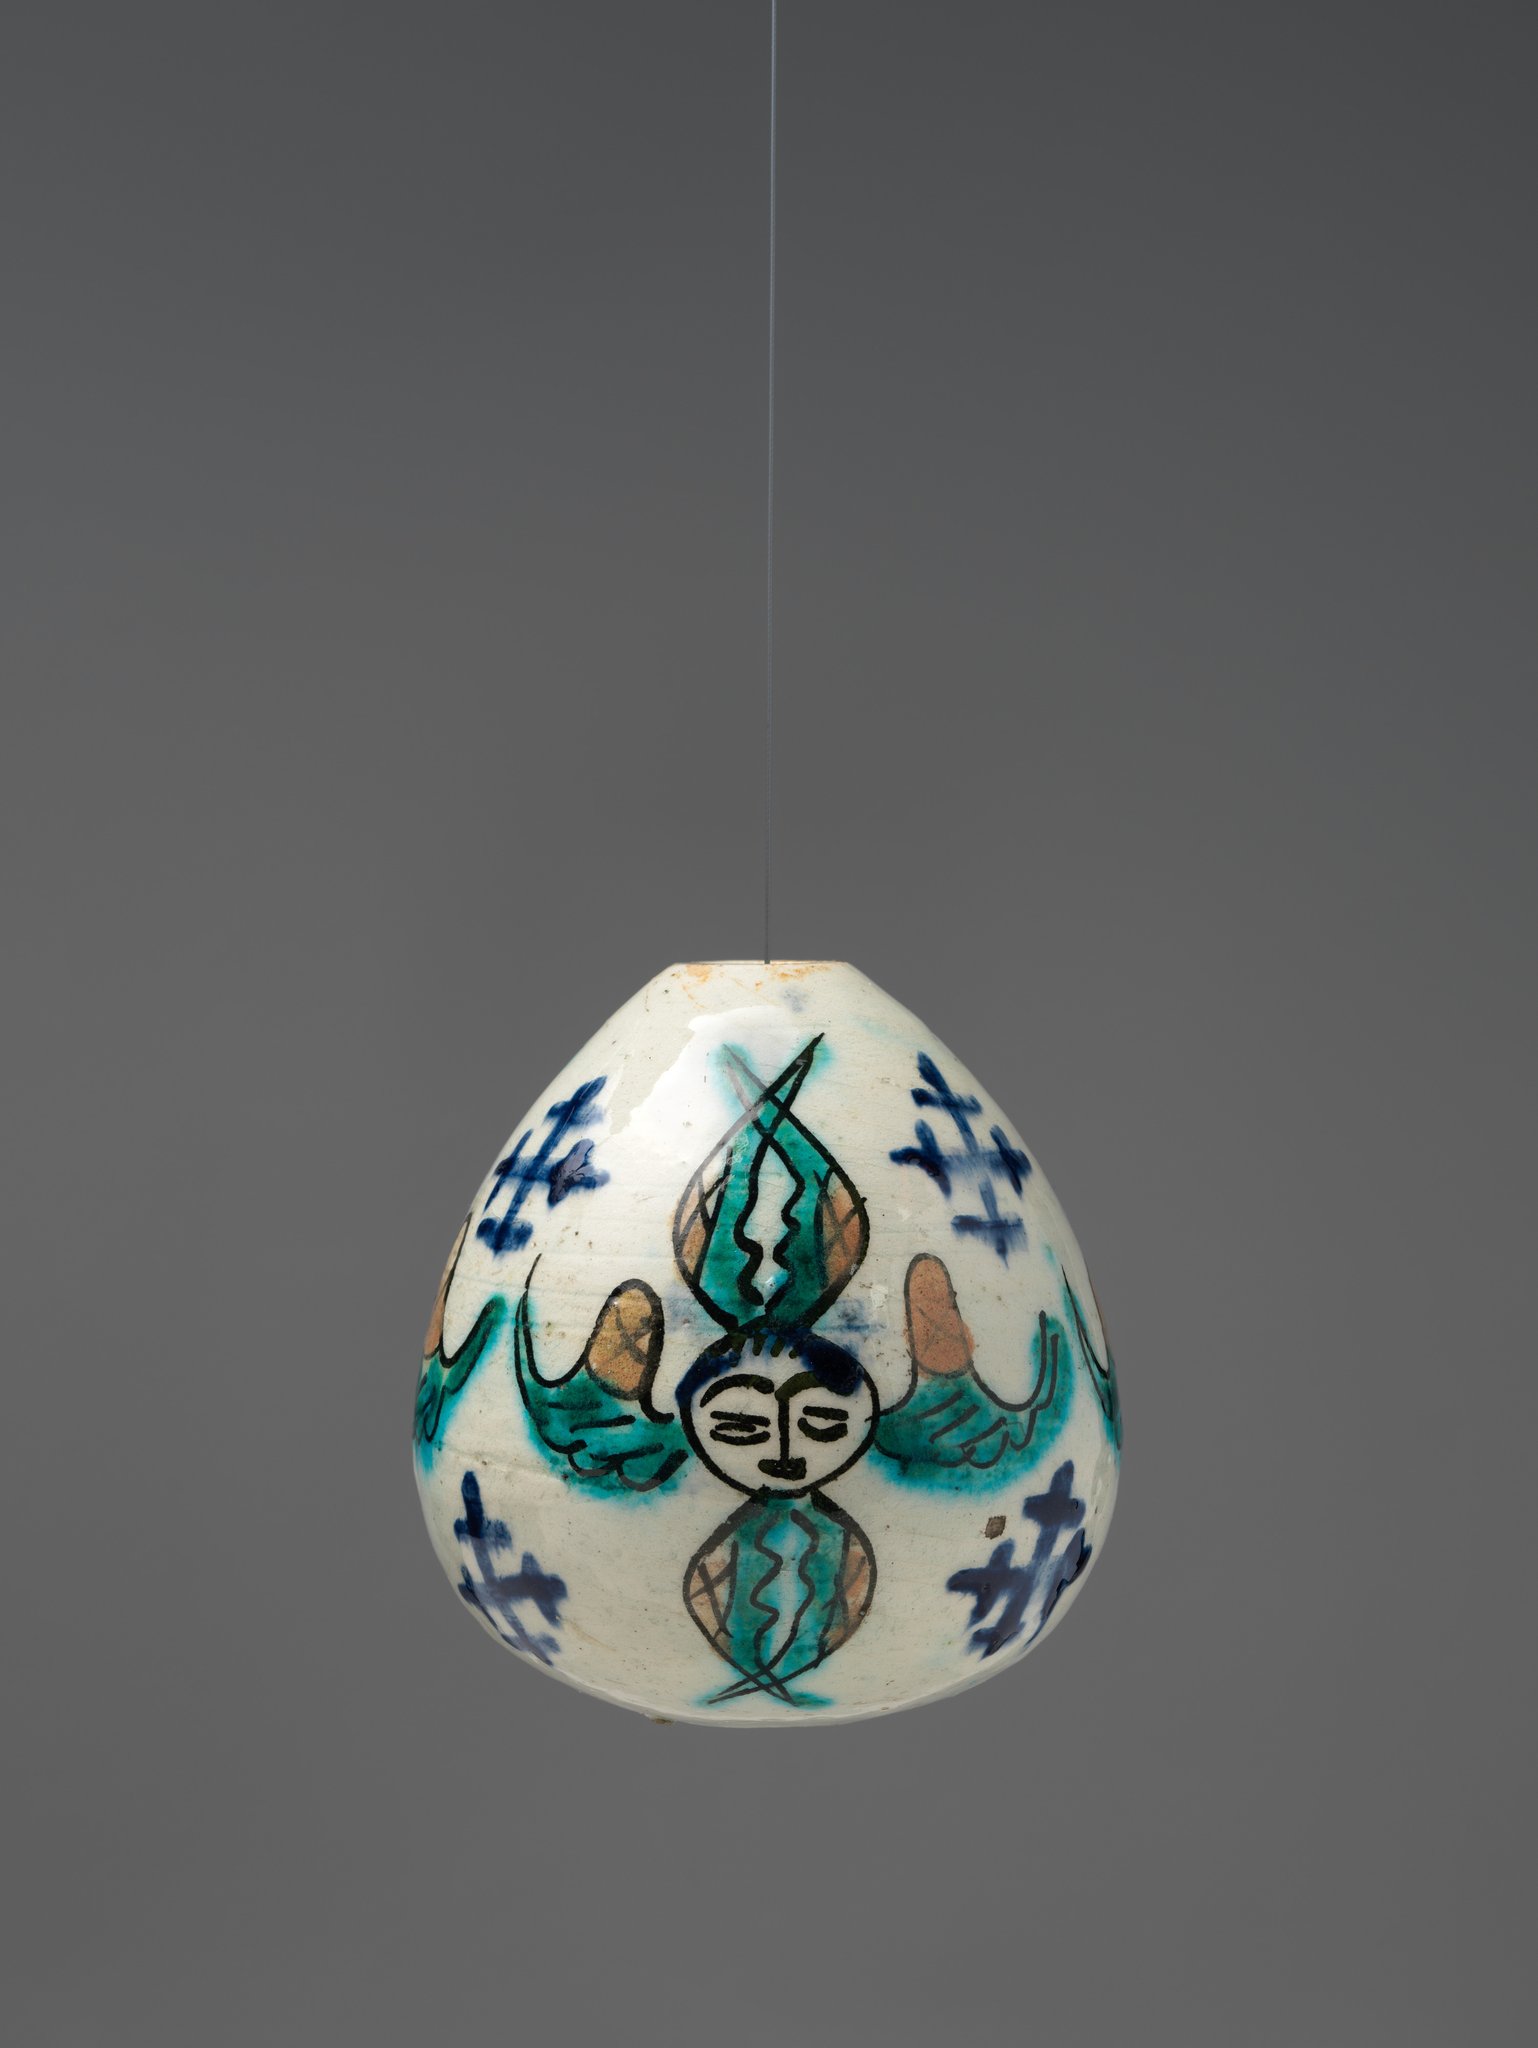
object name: ornament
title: Egg-Shaped Ornament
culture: armenian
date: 1734-1766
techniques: painting, underglaze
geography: kütahya (present-day turkey)